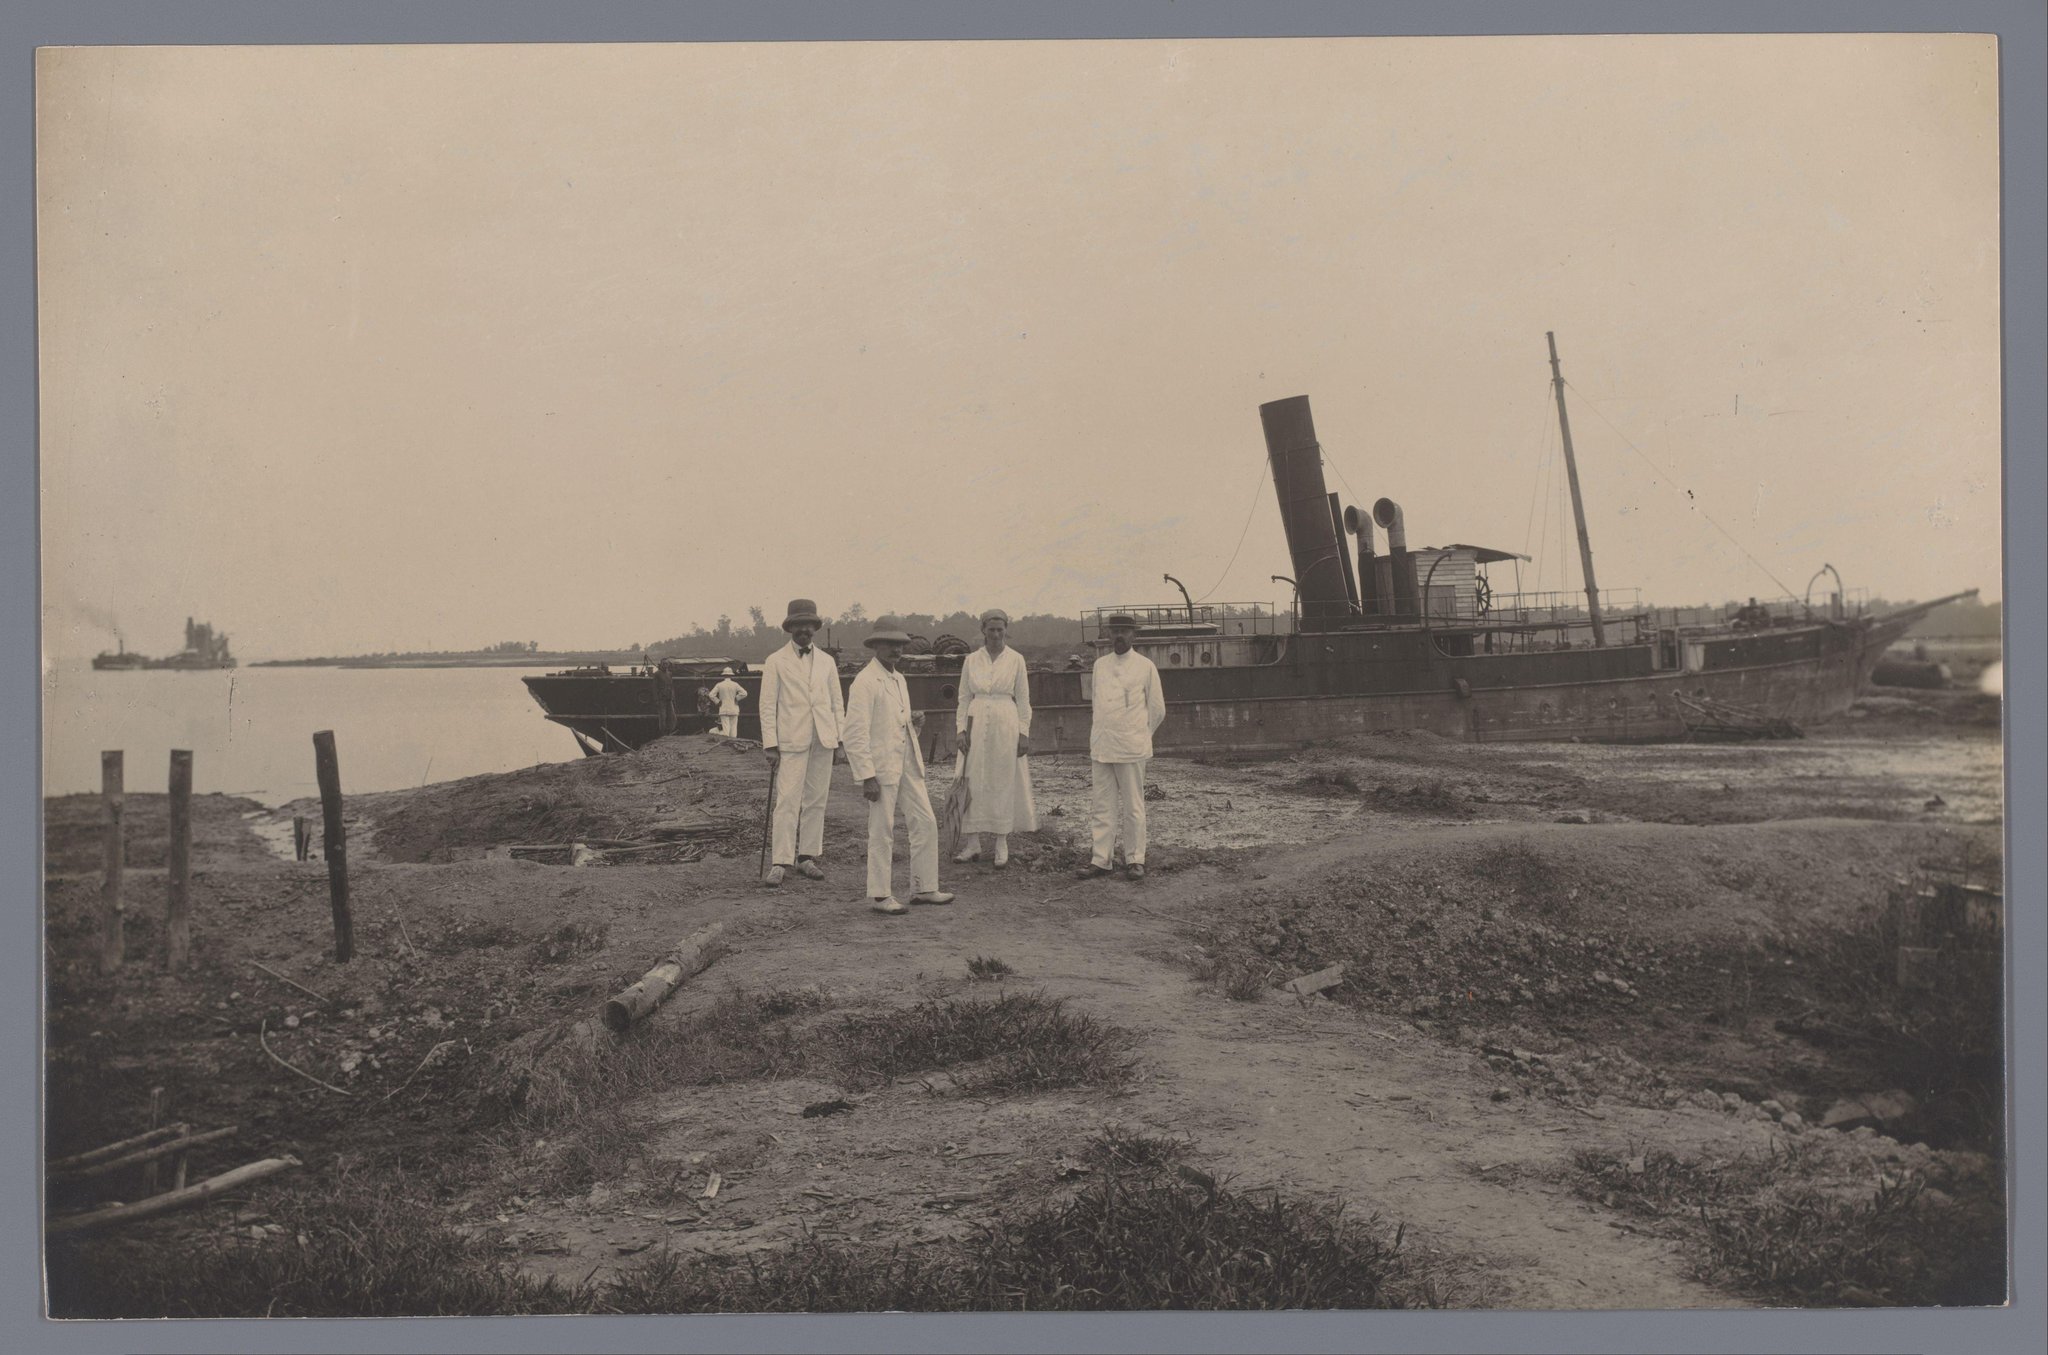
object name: photograph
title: Groep vóór een schip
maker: karl josef john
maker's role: fotograaf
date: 1907-1920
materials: photographic support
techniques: gelatin silver print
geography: belawan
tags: historical persons, building-site, steamship, motorship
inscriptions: workshop stamp: ‘K.J. John / Atelier voor Photographie / Medan Kesawan’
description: Groepsfoto van een vrouw en drie mannen aan de waterkant vóór een schip. Mogelijk de directeur Laurens de Groot met zijn dochter Petronella, tijdens bezoek in juli 1920. Onderdeel van de groep van losse foto's over de aanleg van de haven Belawan aan de kust voor Medan, Sumatra 1921-1922.